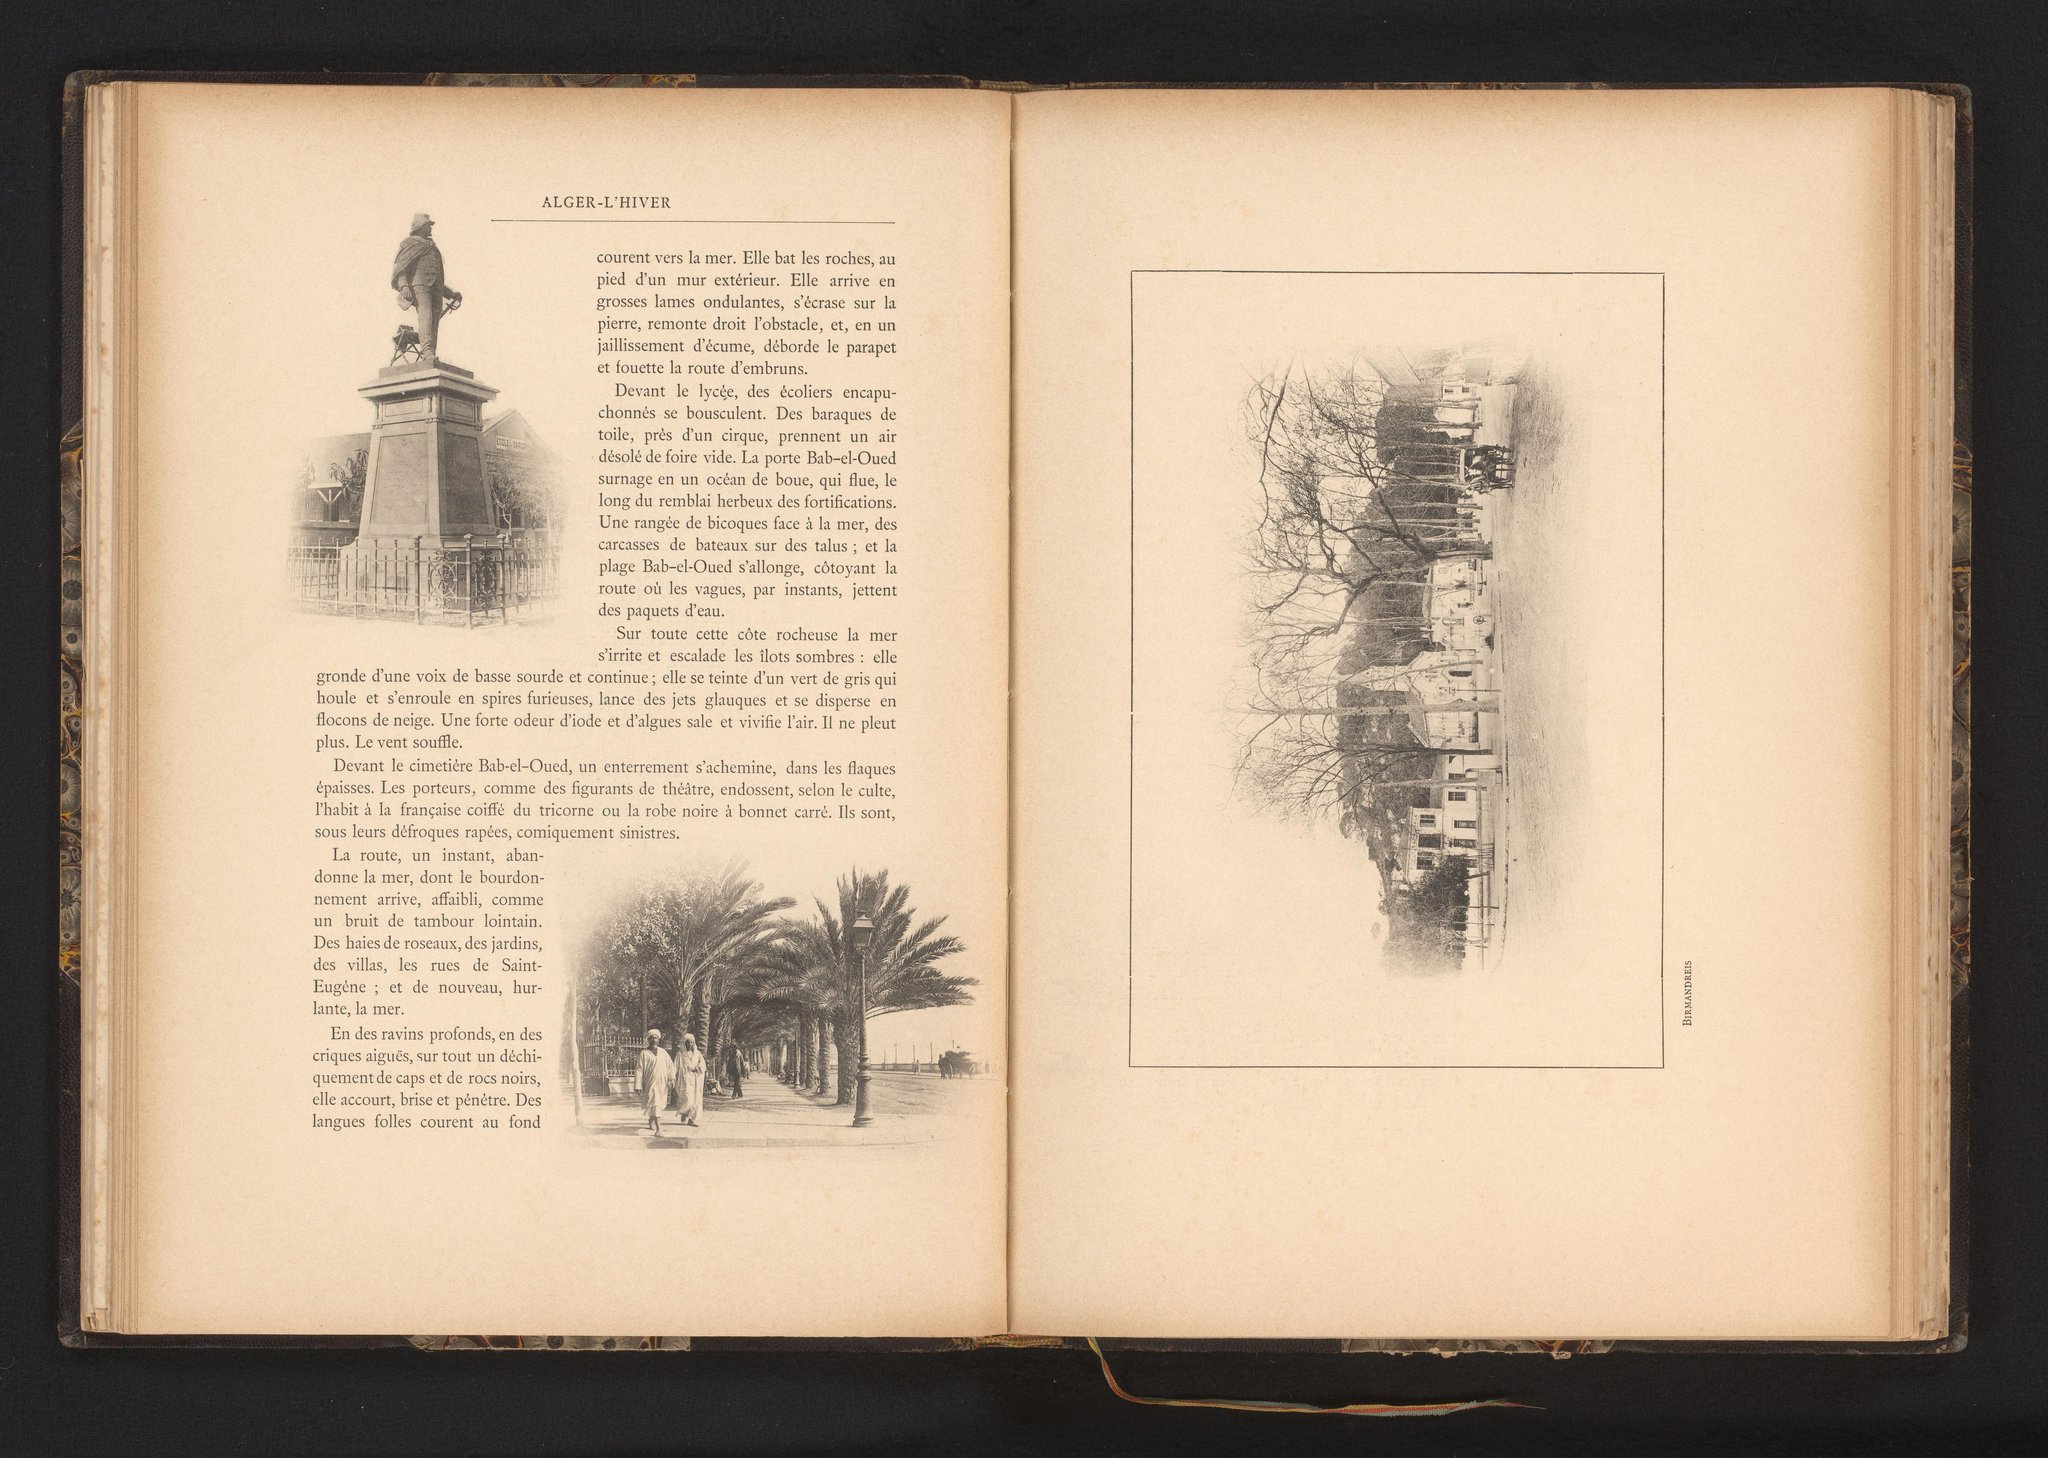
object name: page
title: Birmandreis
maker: jules gervais-courtellemont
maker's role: fotograaf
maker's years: 1863-1931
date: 1888-1893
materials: paper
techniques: photograph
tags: prospect of city, town panorama, silhouette of city